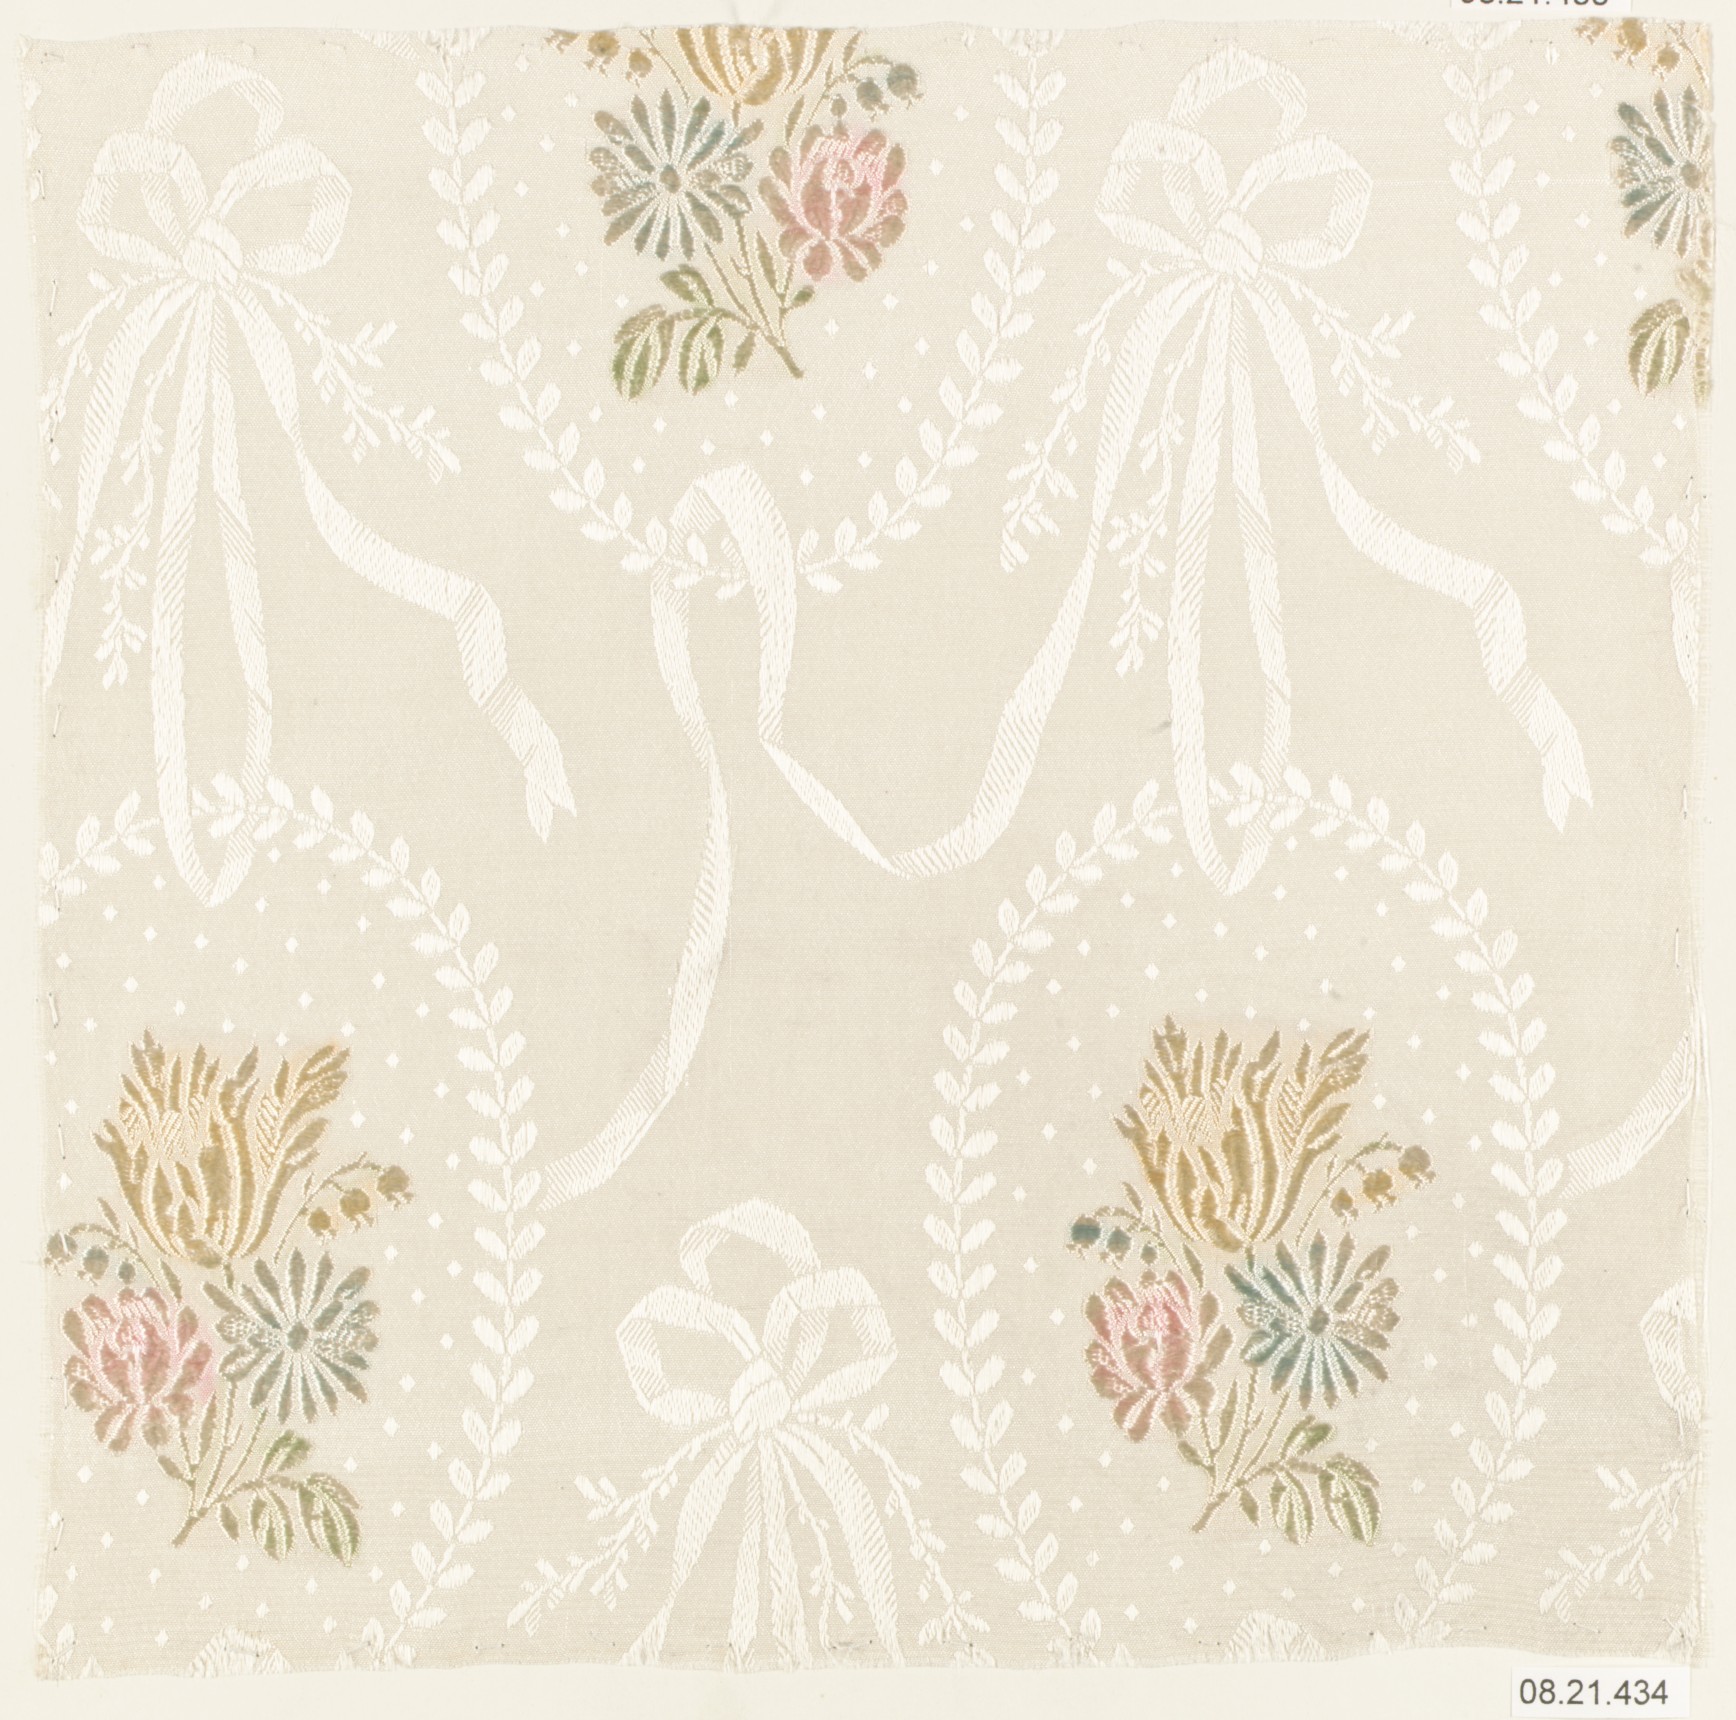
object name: textile sample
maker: Anonymous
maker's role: designer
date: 1900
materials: silk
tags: flowers